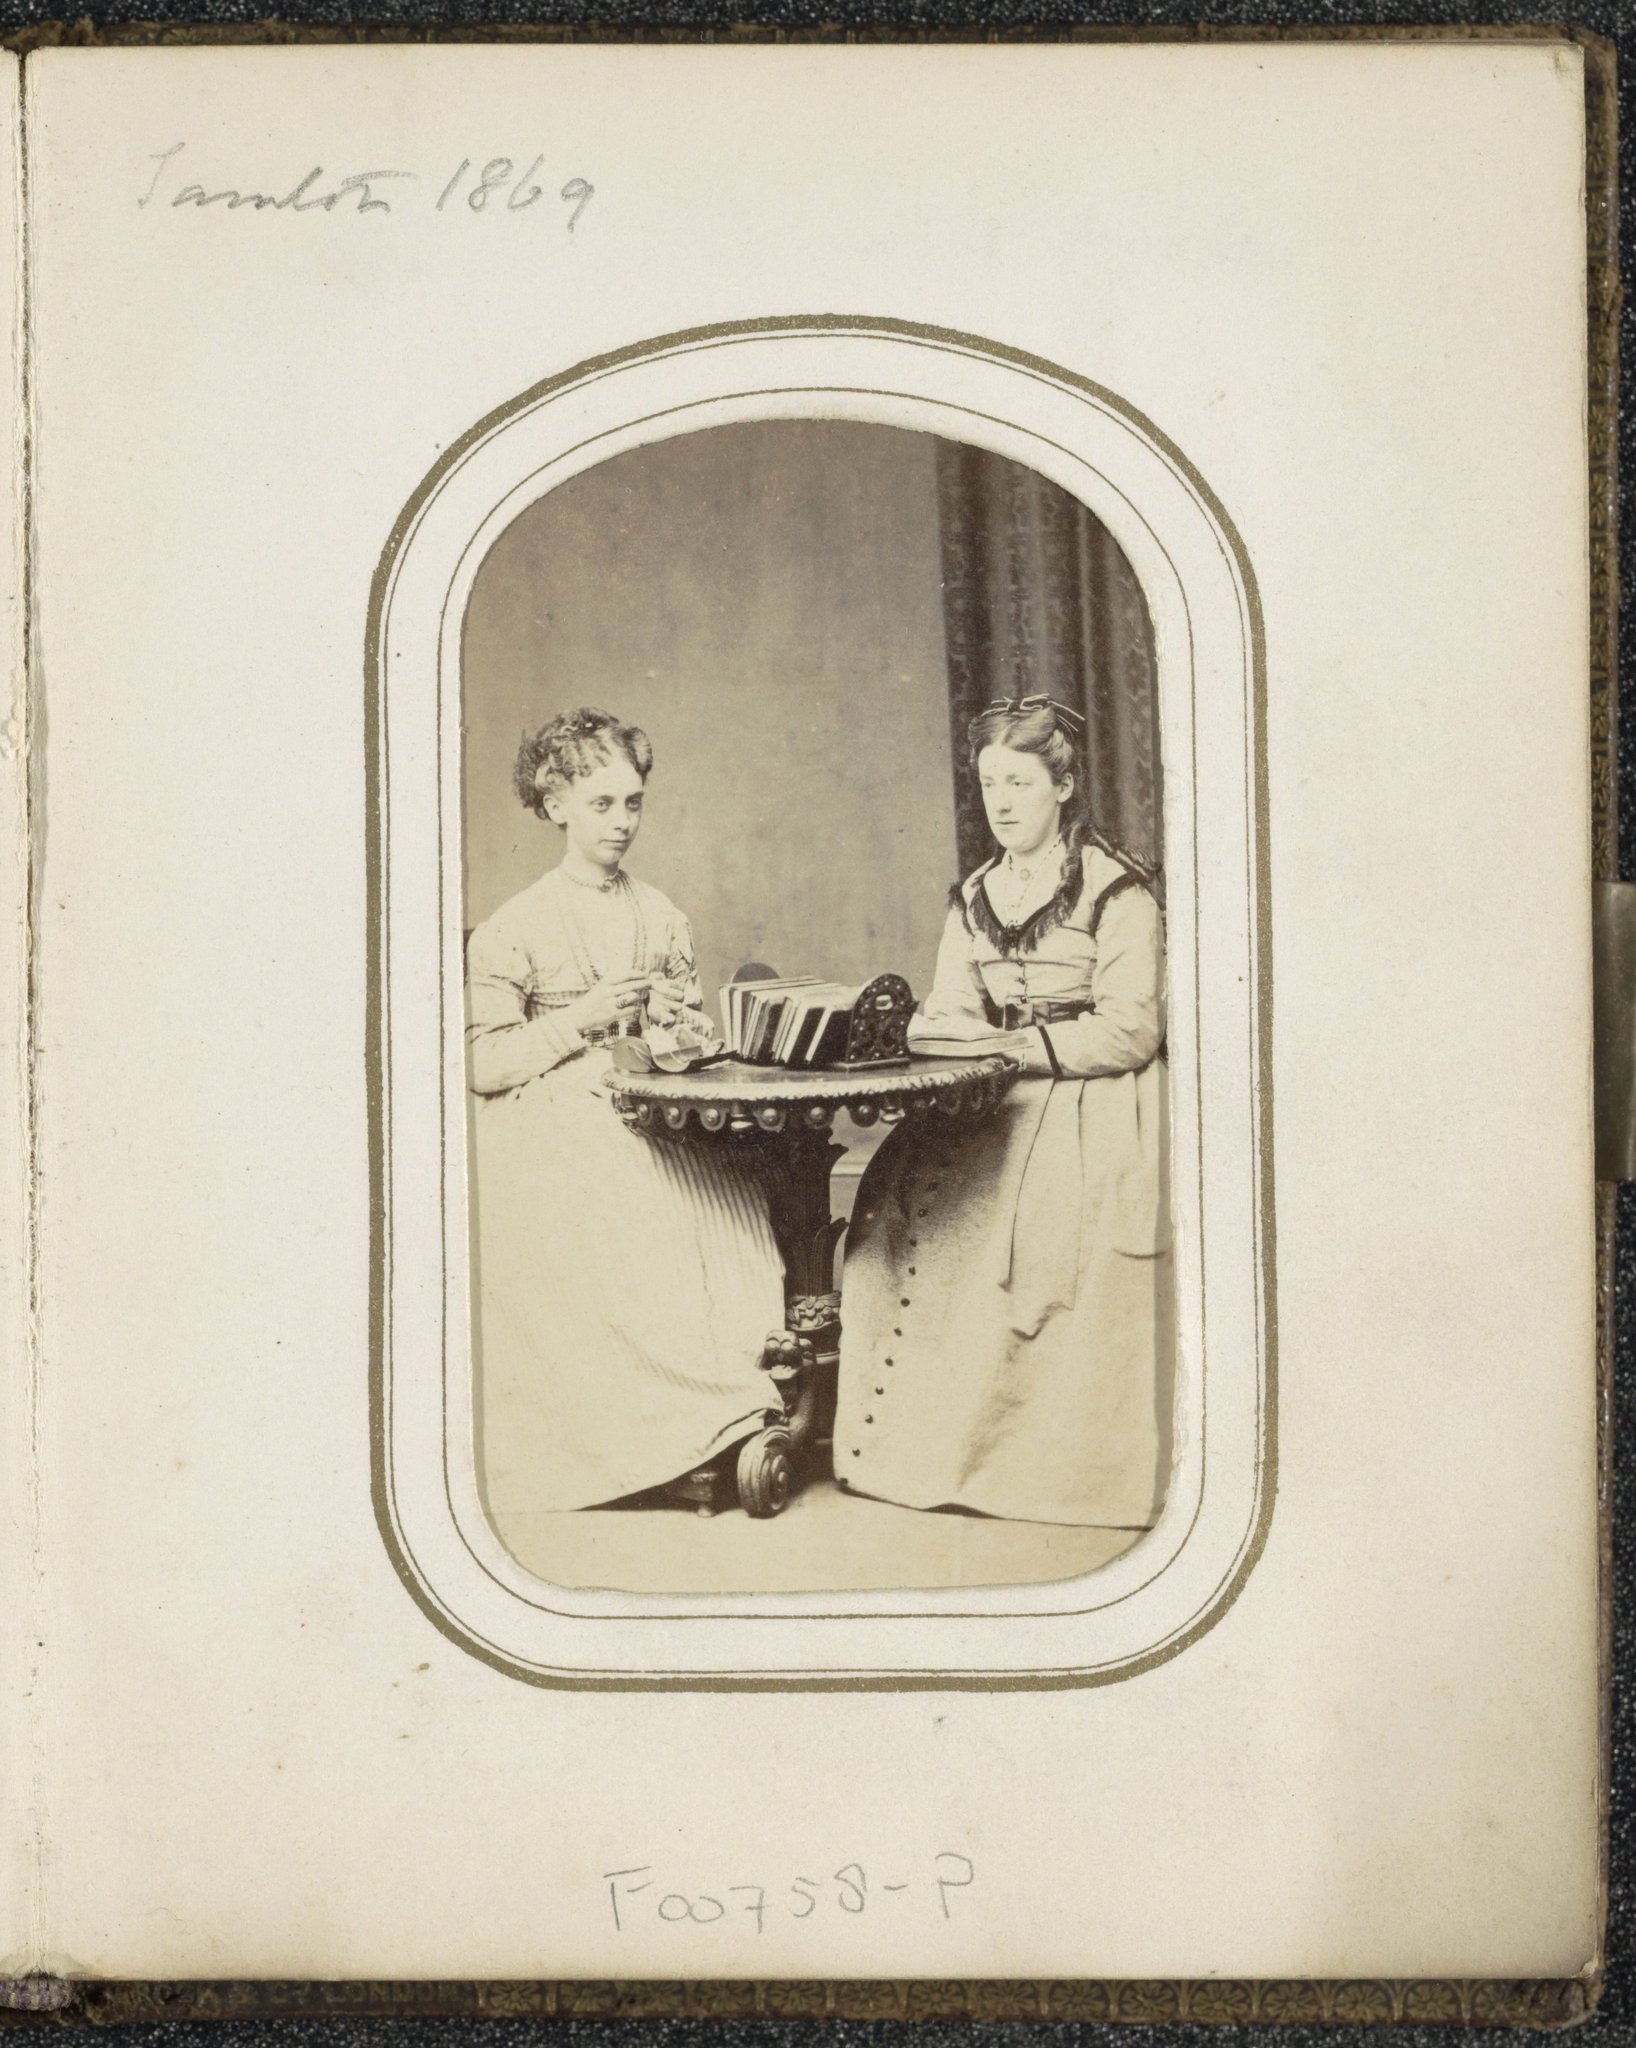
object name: photograph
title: Portret van twee vrouwen bij een tafel met boeken in een standaard en handwerk in een doos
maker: j.e. blizzard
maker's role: fotograaf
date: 1869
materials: cardboard, paper, photographic support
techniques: albumen print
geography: taunton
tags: studio requisites ~ photographer, historical persons, book, (other forms of) needlework, e.g.: crocheting, knitting, embroidering, dress, gown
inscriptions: address: ‘Taunton, 52 East Street’, inscription: ‘Taunton 1869’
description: Onderdeel van Engels fotoalbum van E.A. Kettle met 42 cartes-de-visite.